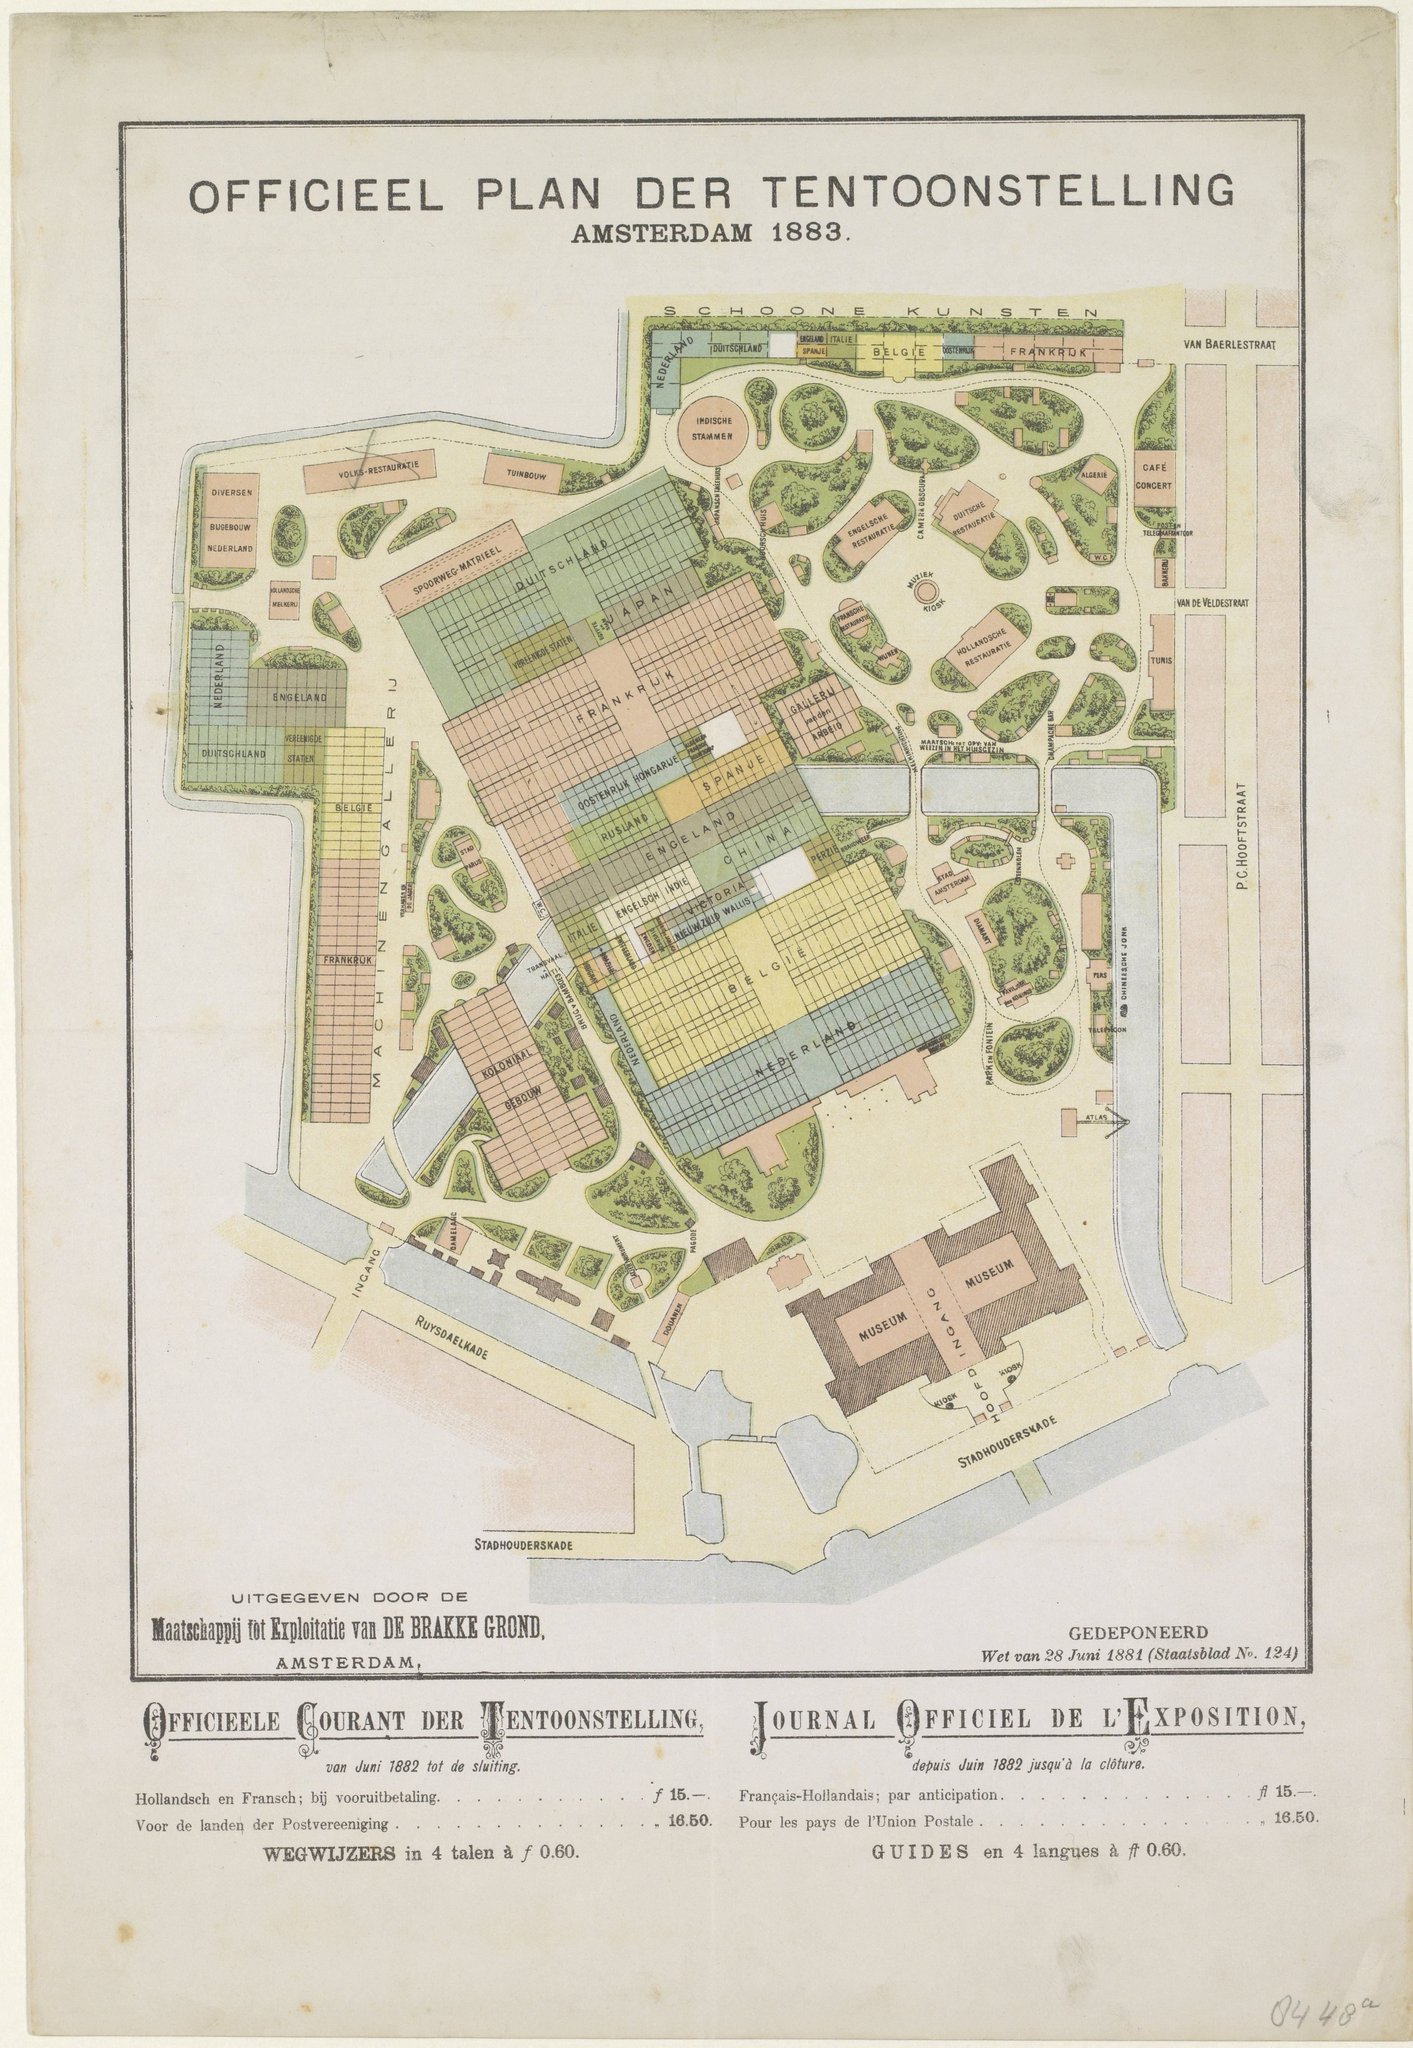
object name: print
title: Officieel plan der tentoonstelling Amsterdam 1883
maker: Anonymous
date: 1883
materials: paper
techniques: chromolithography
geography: netherlands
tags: world fair, world exhibition, amsterdam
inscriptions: : ‘Gedeponeerd’, collector's mark: Lugt 2228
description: Plattegrond (klein formaat) van het terrein van de Wereldtentoonstelling (Internationale Koloniale en Uitvoerhandel Tentoonstelling) gehouden op het Museumplein te Amsterdam, van 1 mei tot 1 oktober 1883.